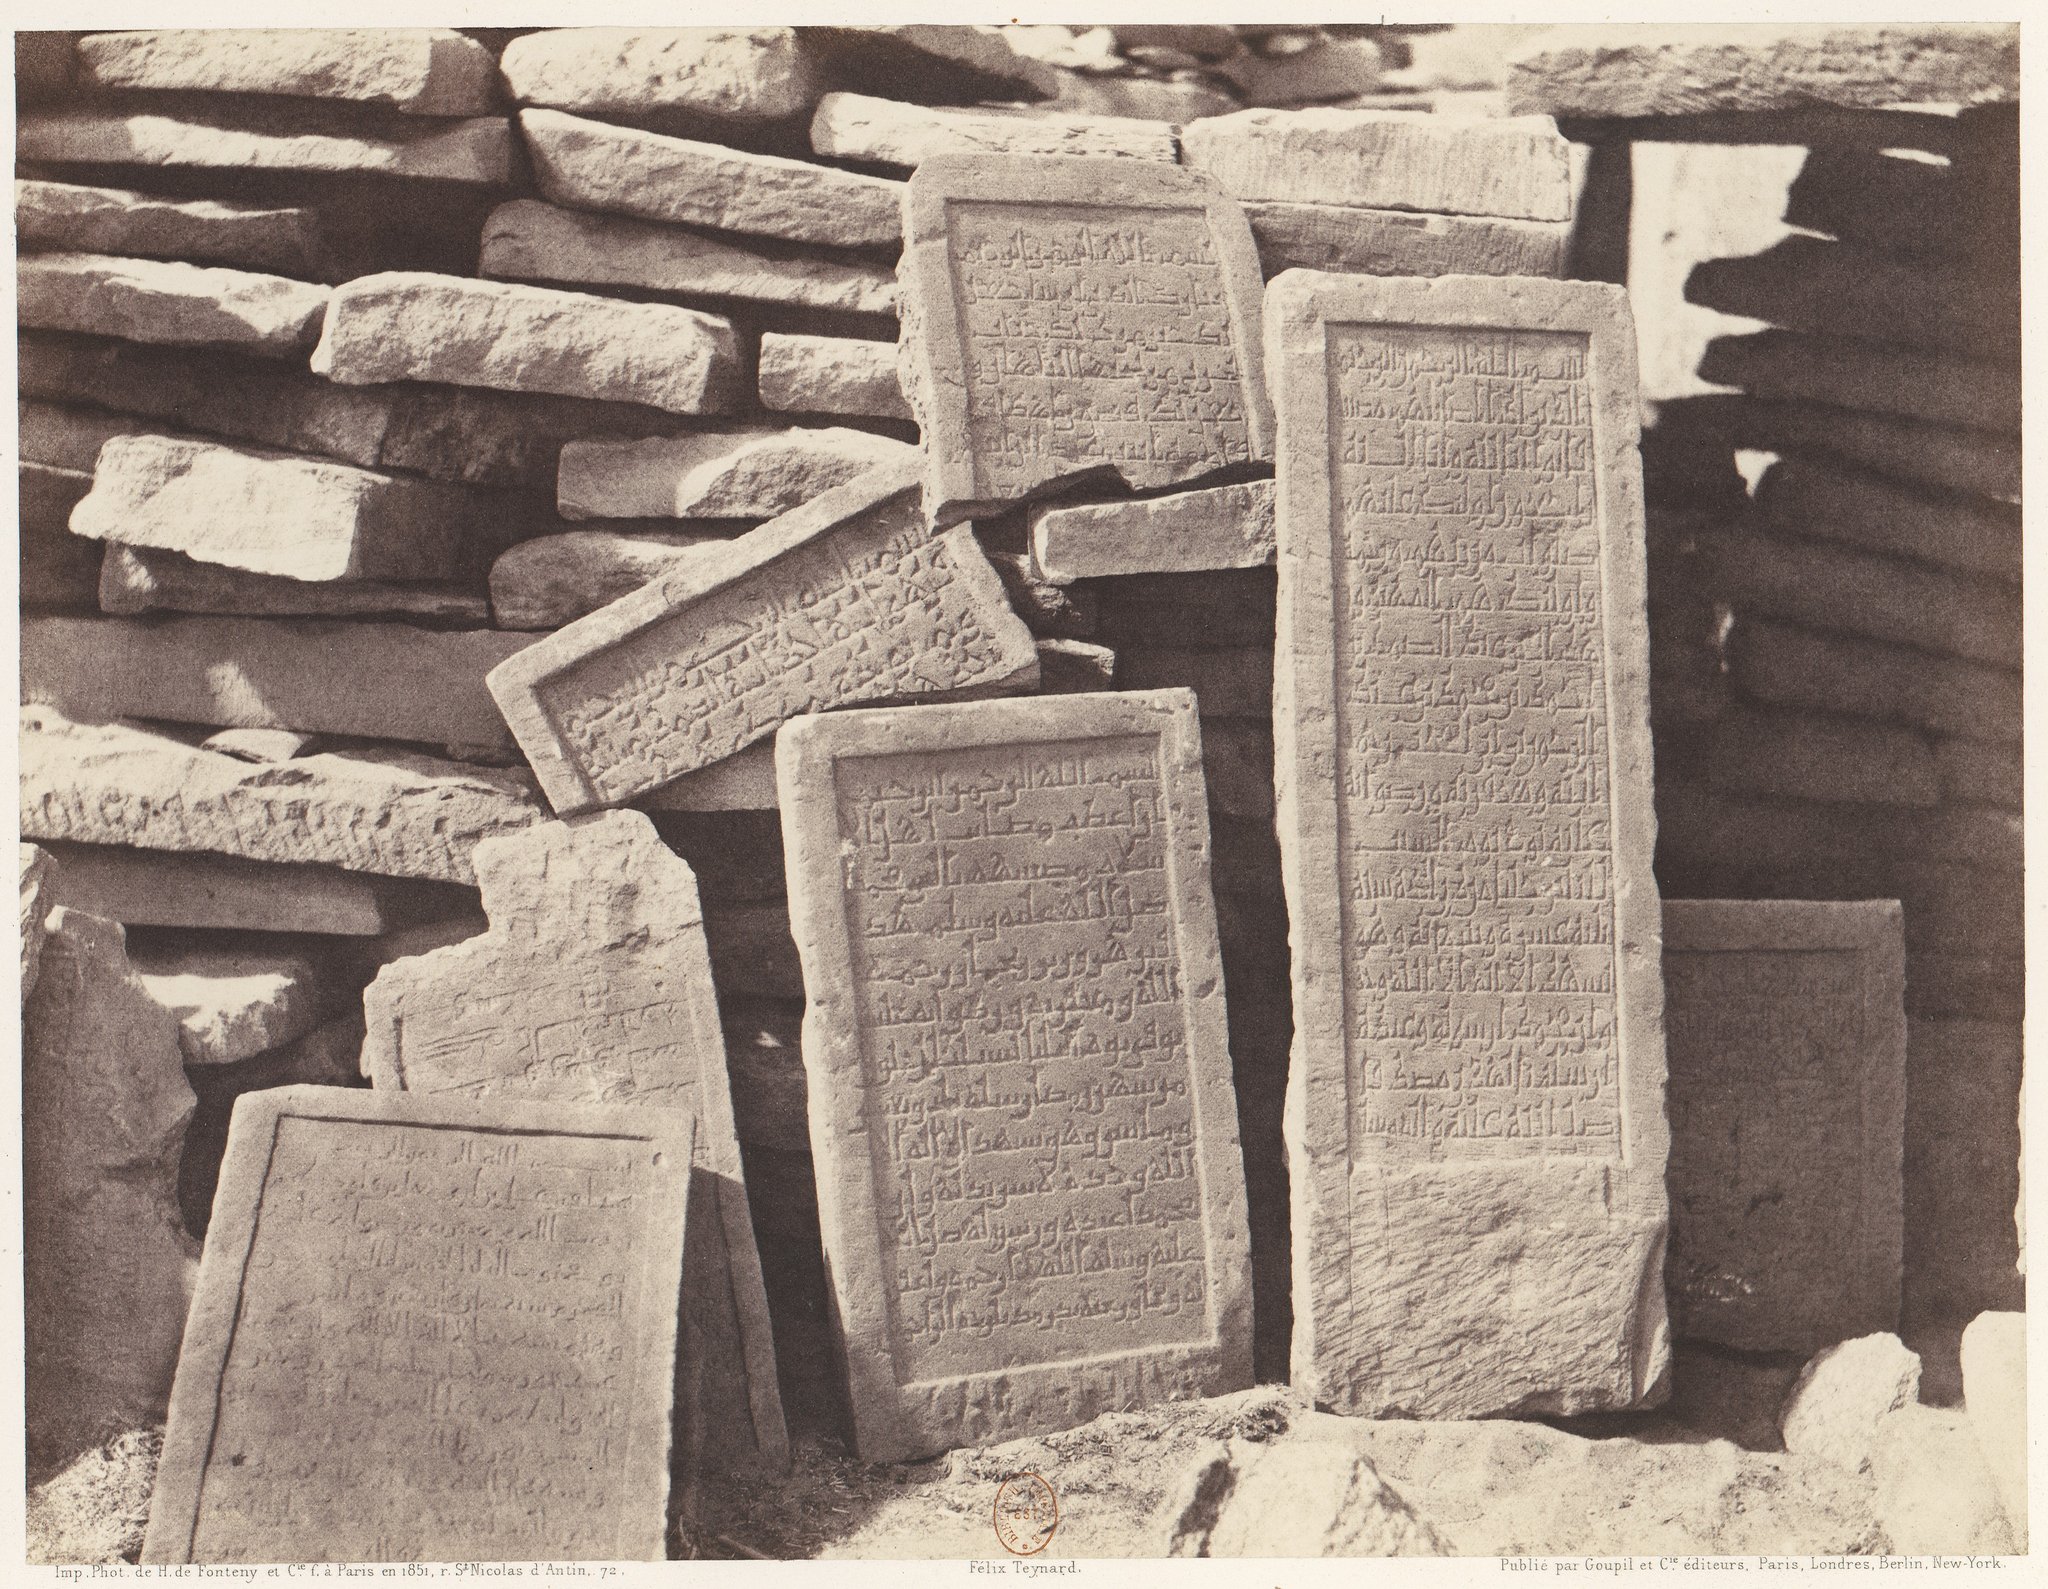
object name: photograph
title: Assouan, Cimetière Arabe - Inscription Funéraires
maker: félix teynard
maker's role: artist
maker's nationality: french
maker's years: 1817-1892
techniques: paper negative, salted paper print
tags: cemeteries